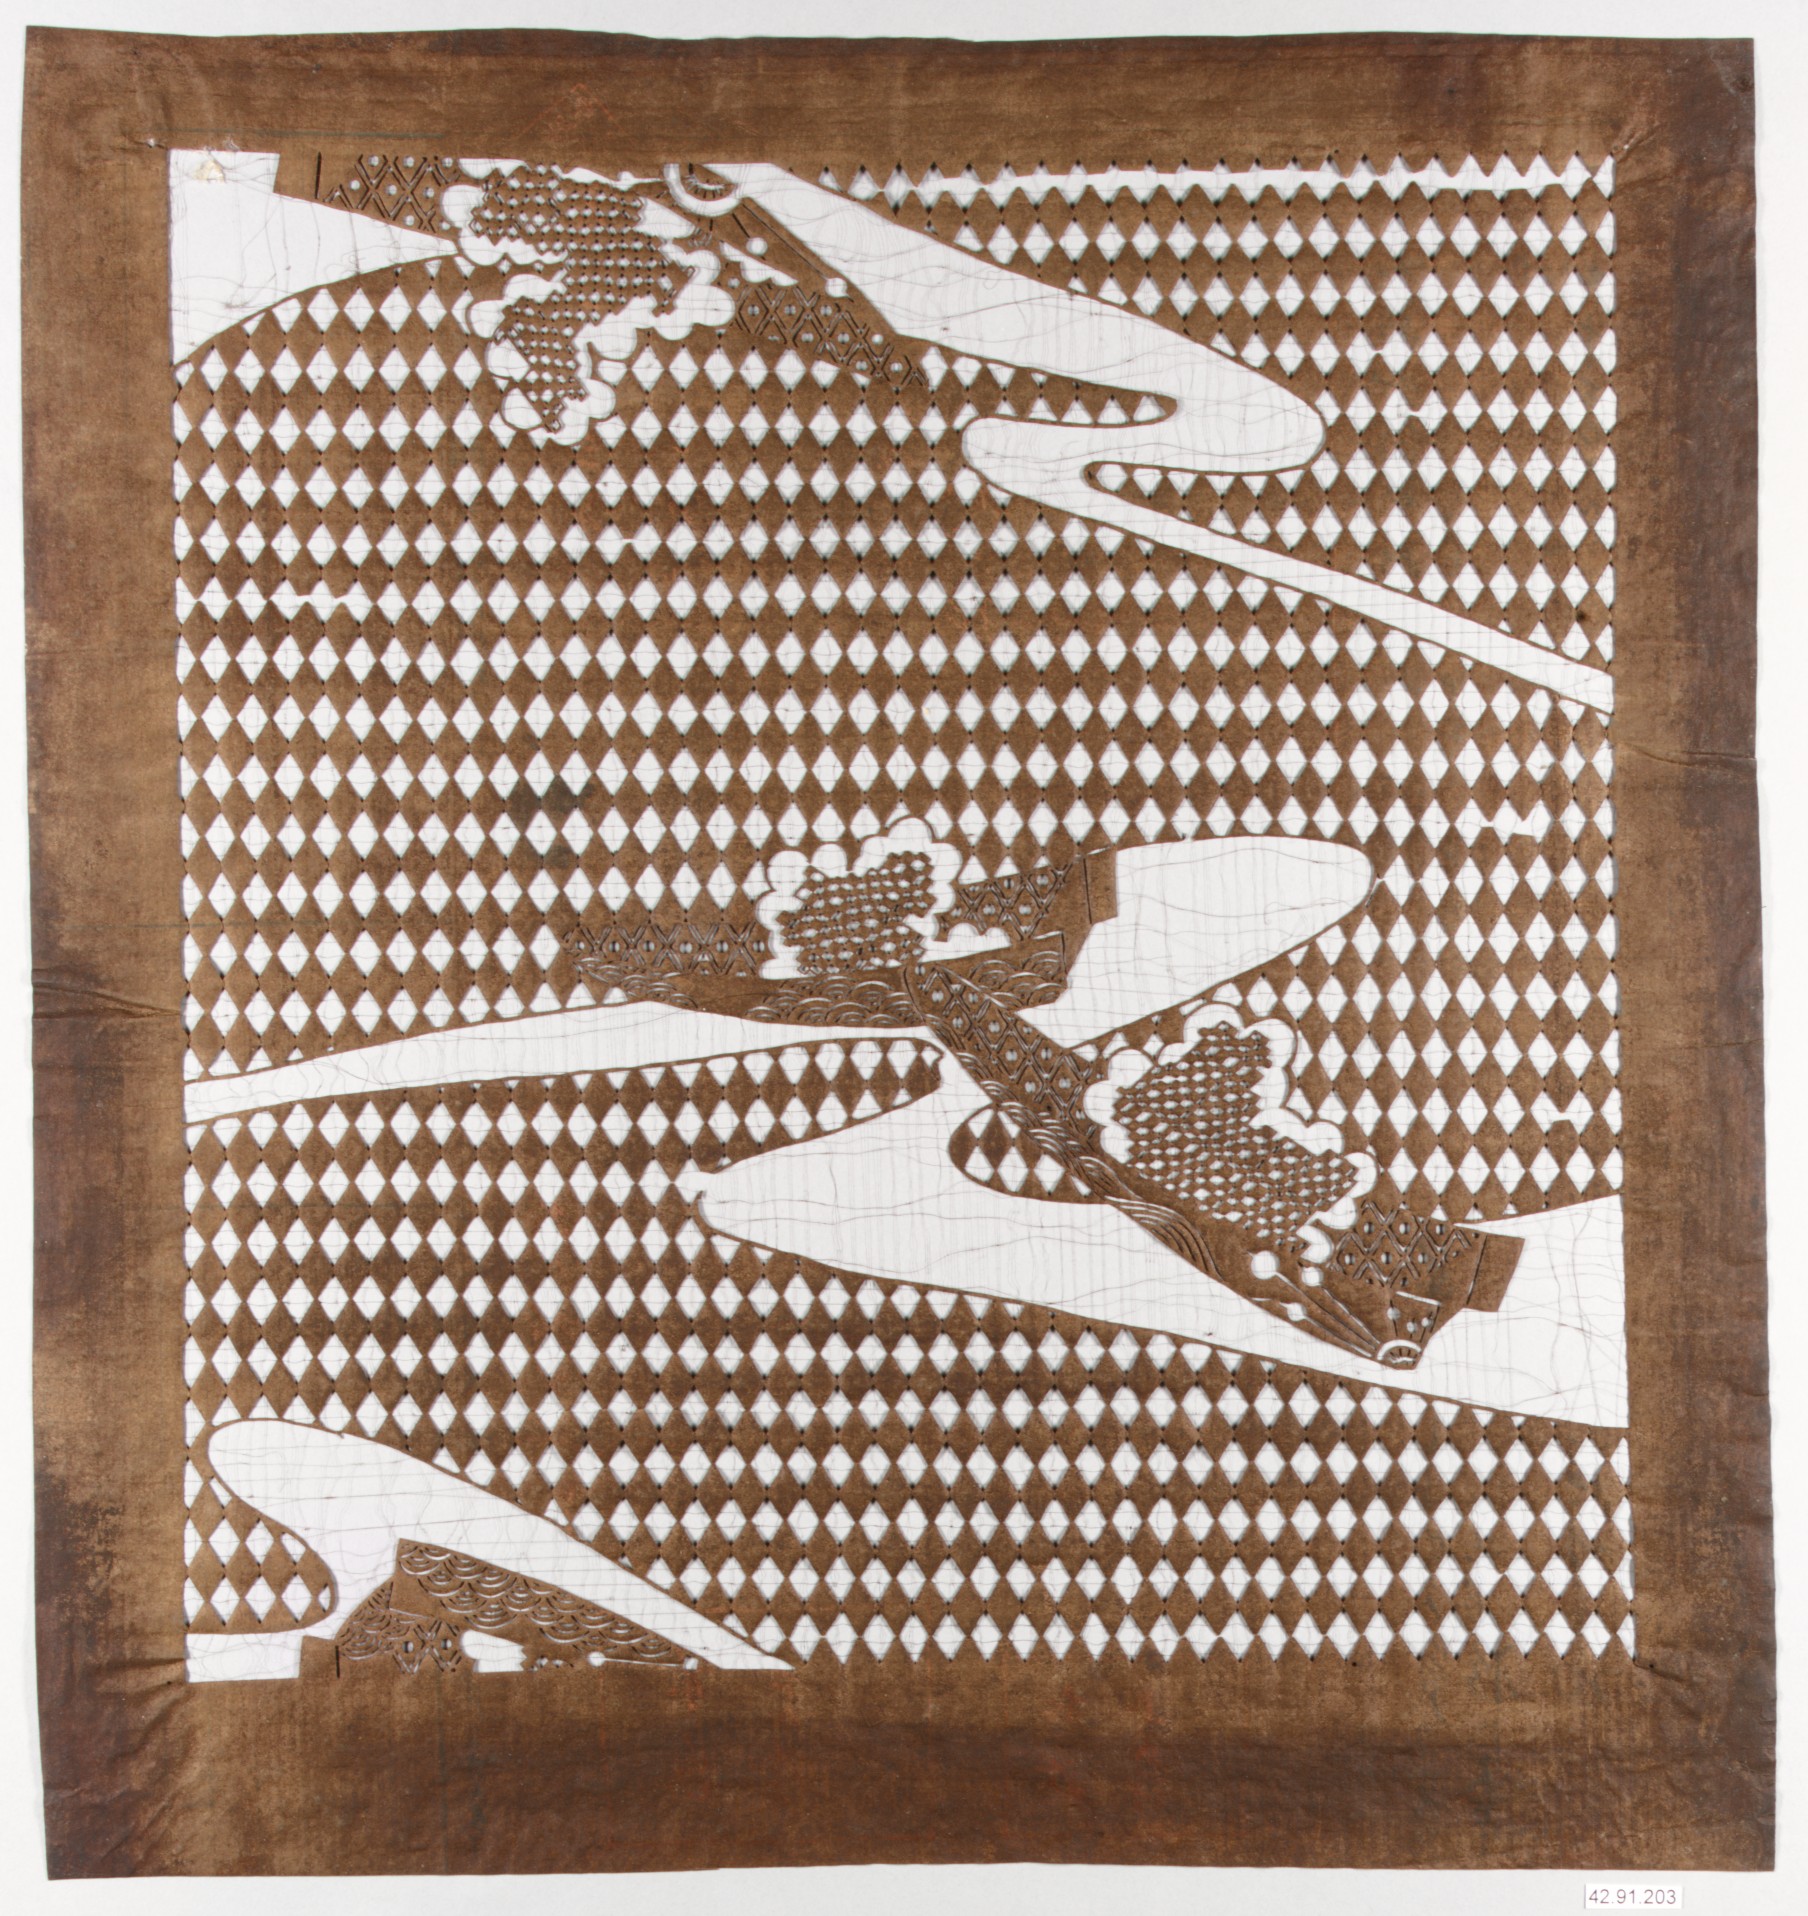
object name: stencil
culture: japanese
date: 1801-1900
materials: paper, silk